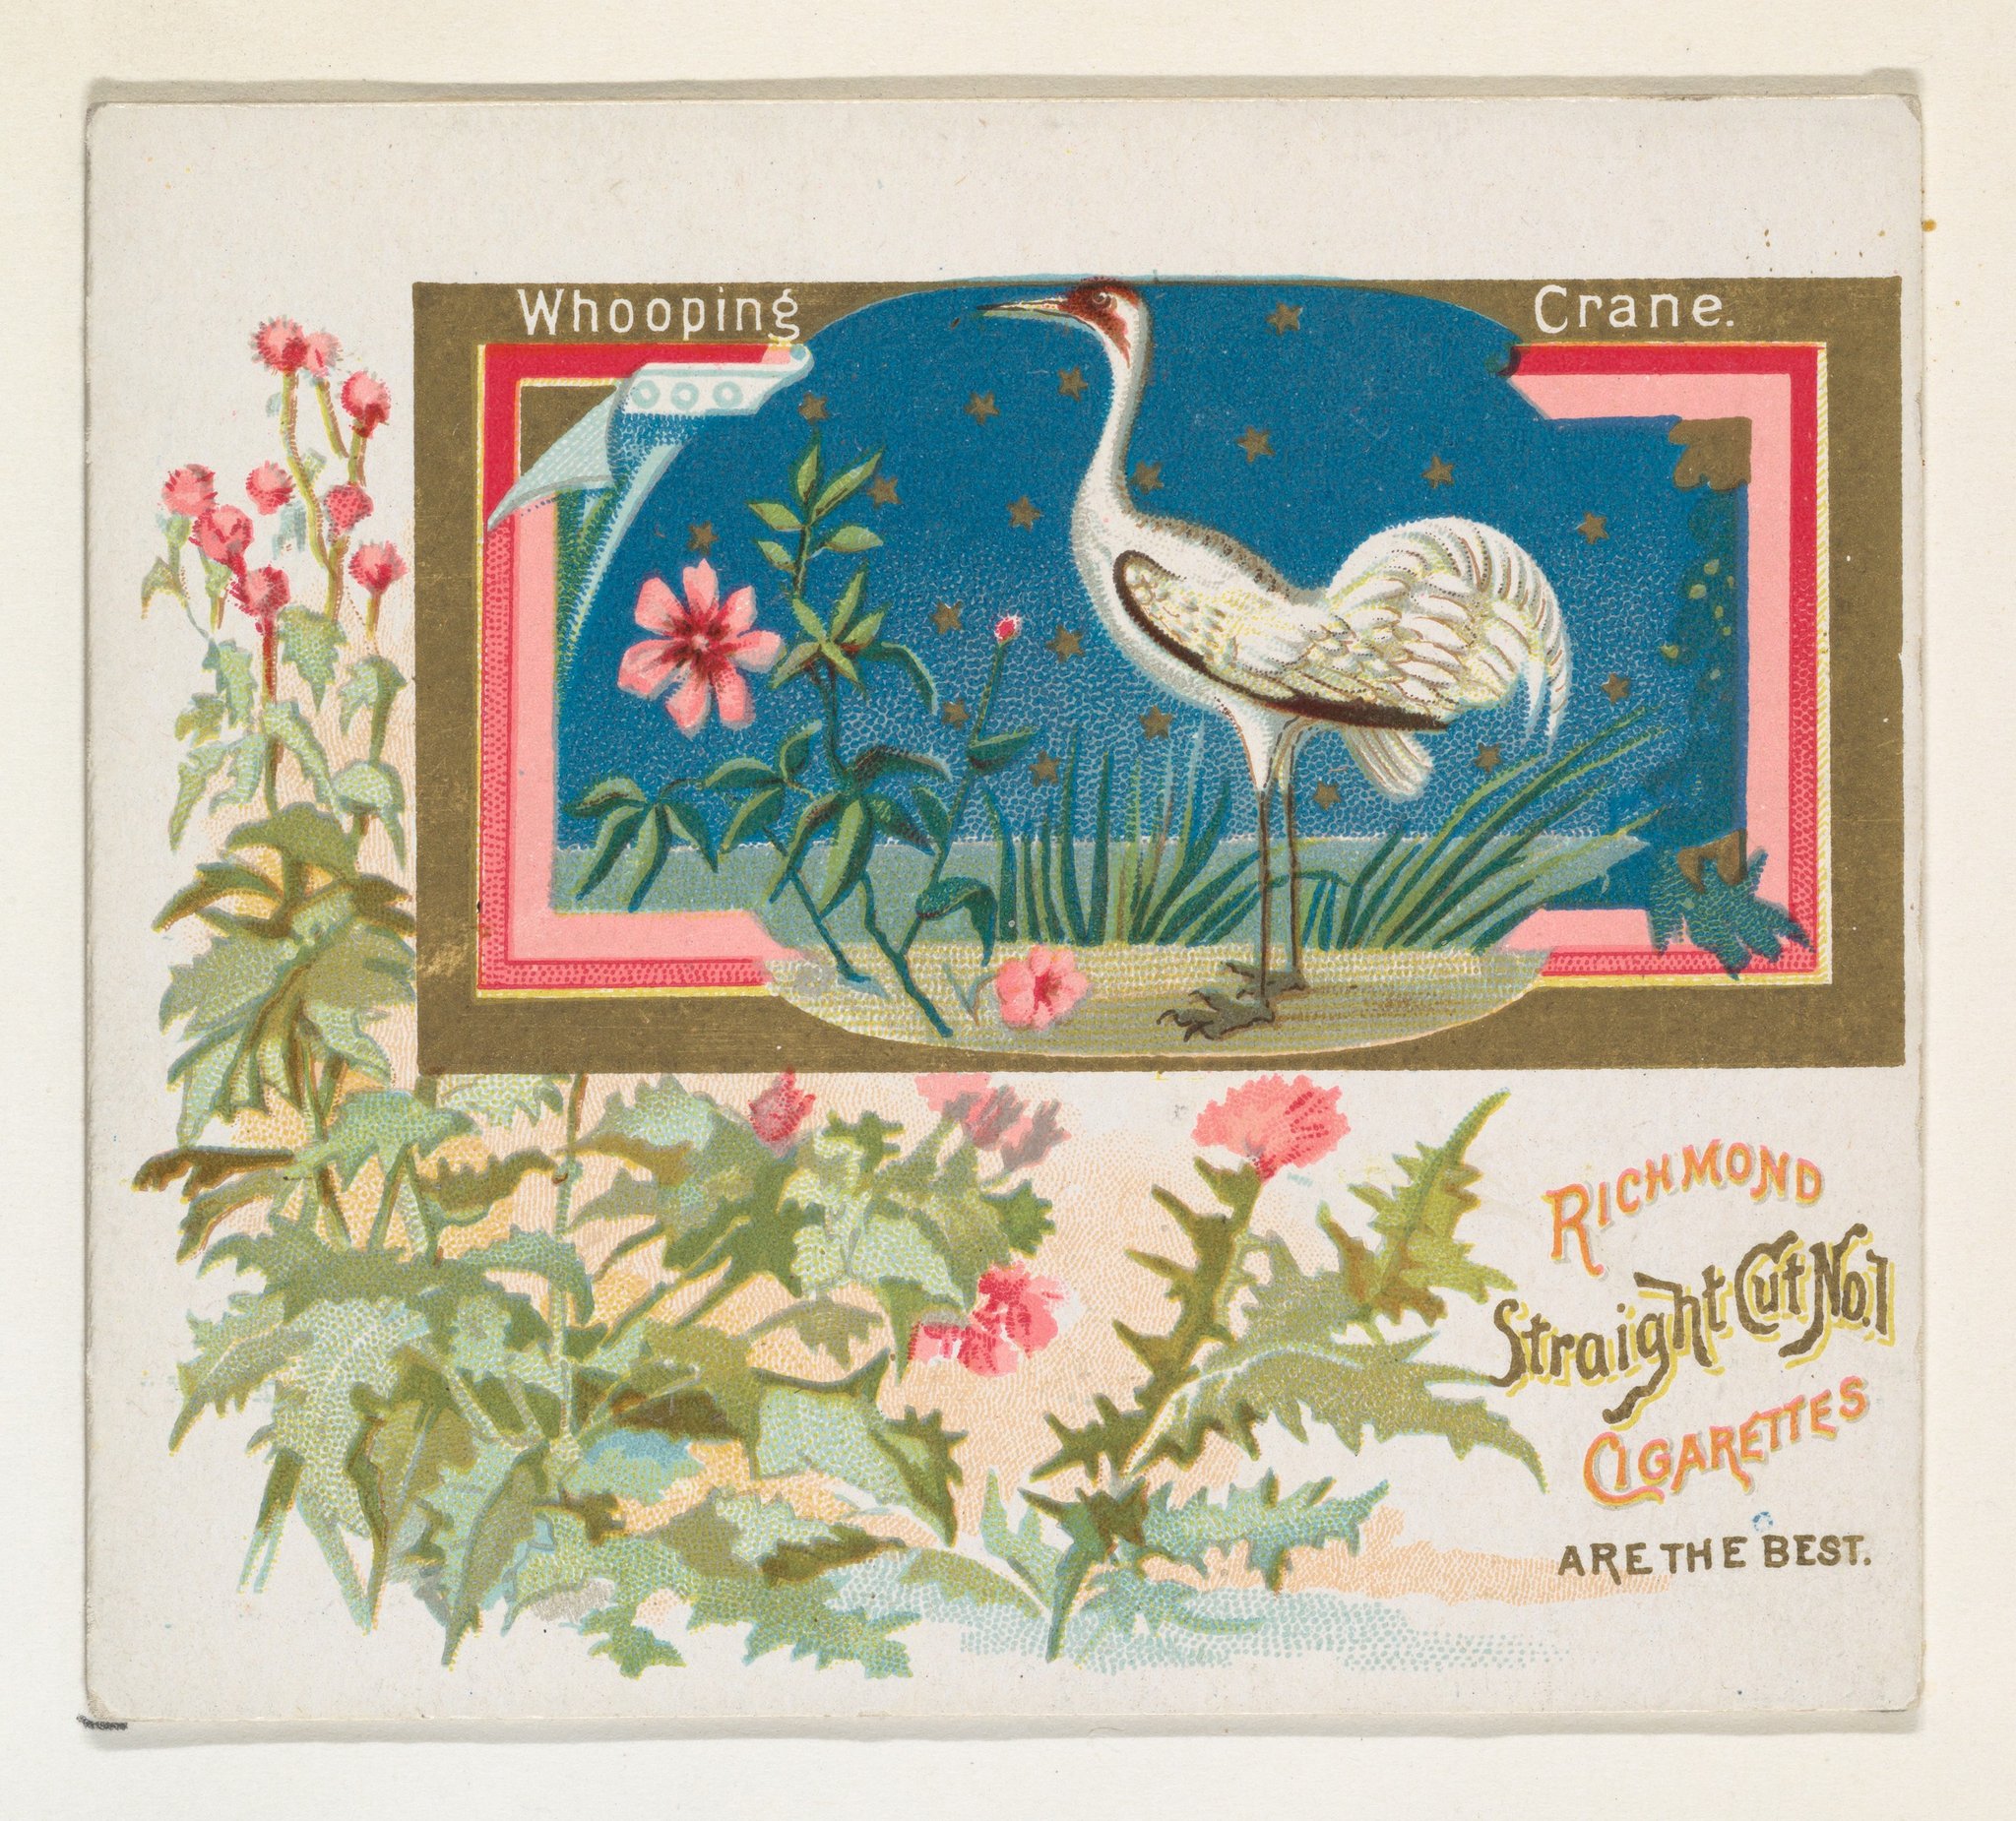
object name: print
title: Whooping Crane, from the Game Birds series (N40) for Allen & Ginter Cigarettes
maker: allen & ginter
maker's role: publisher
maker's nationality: american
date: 1888-1890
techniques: color lithograph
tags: cranes